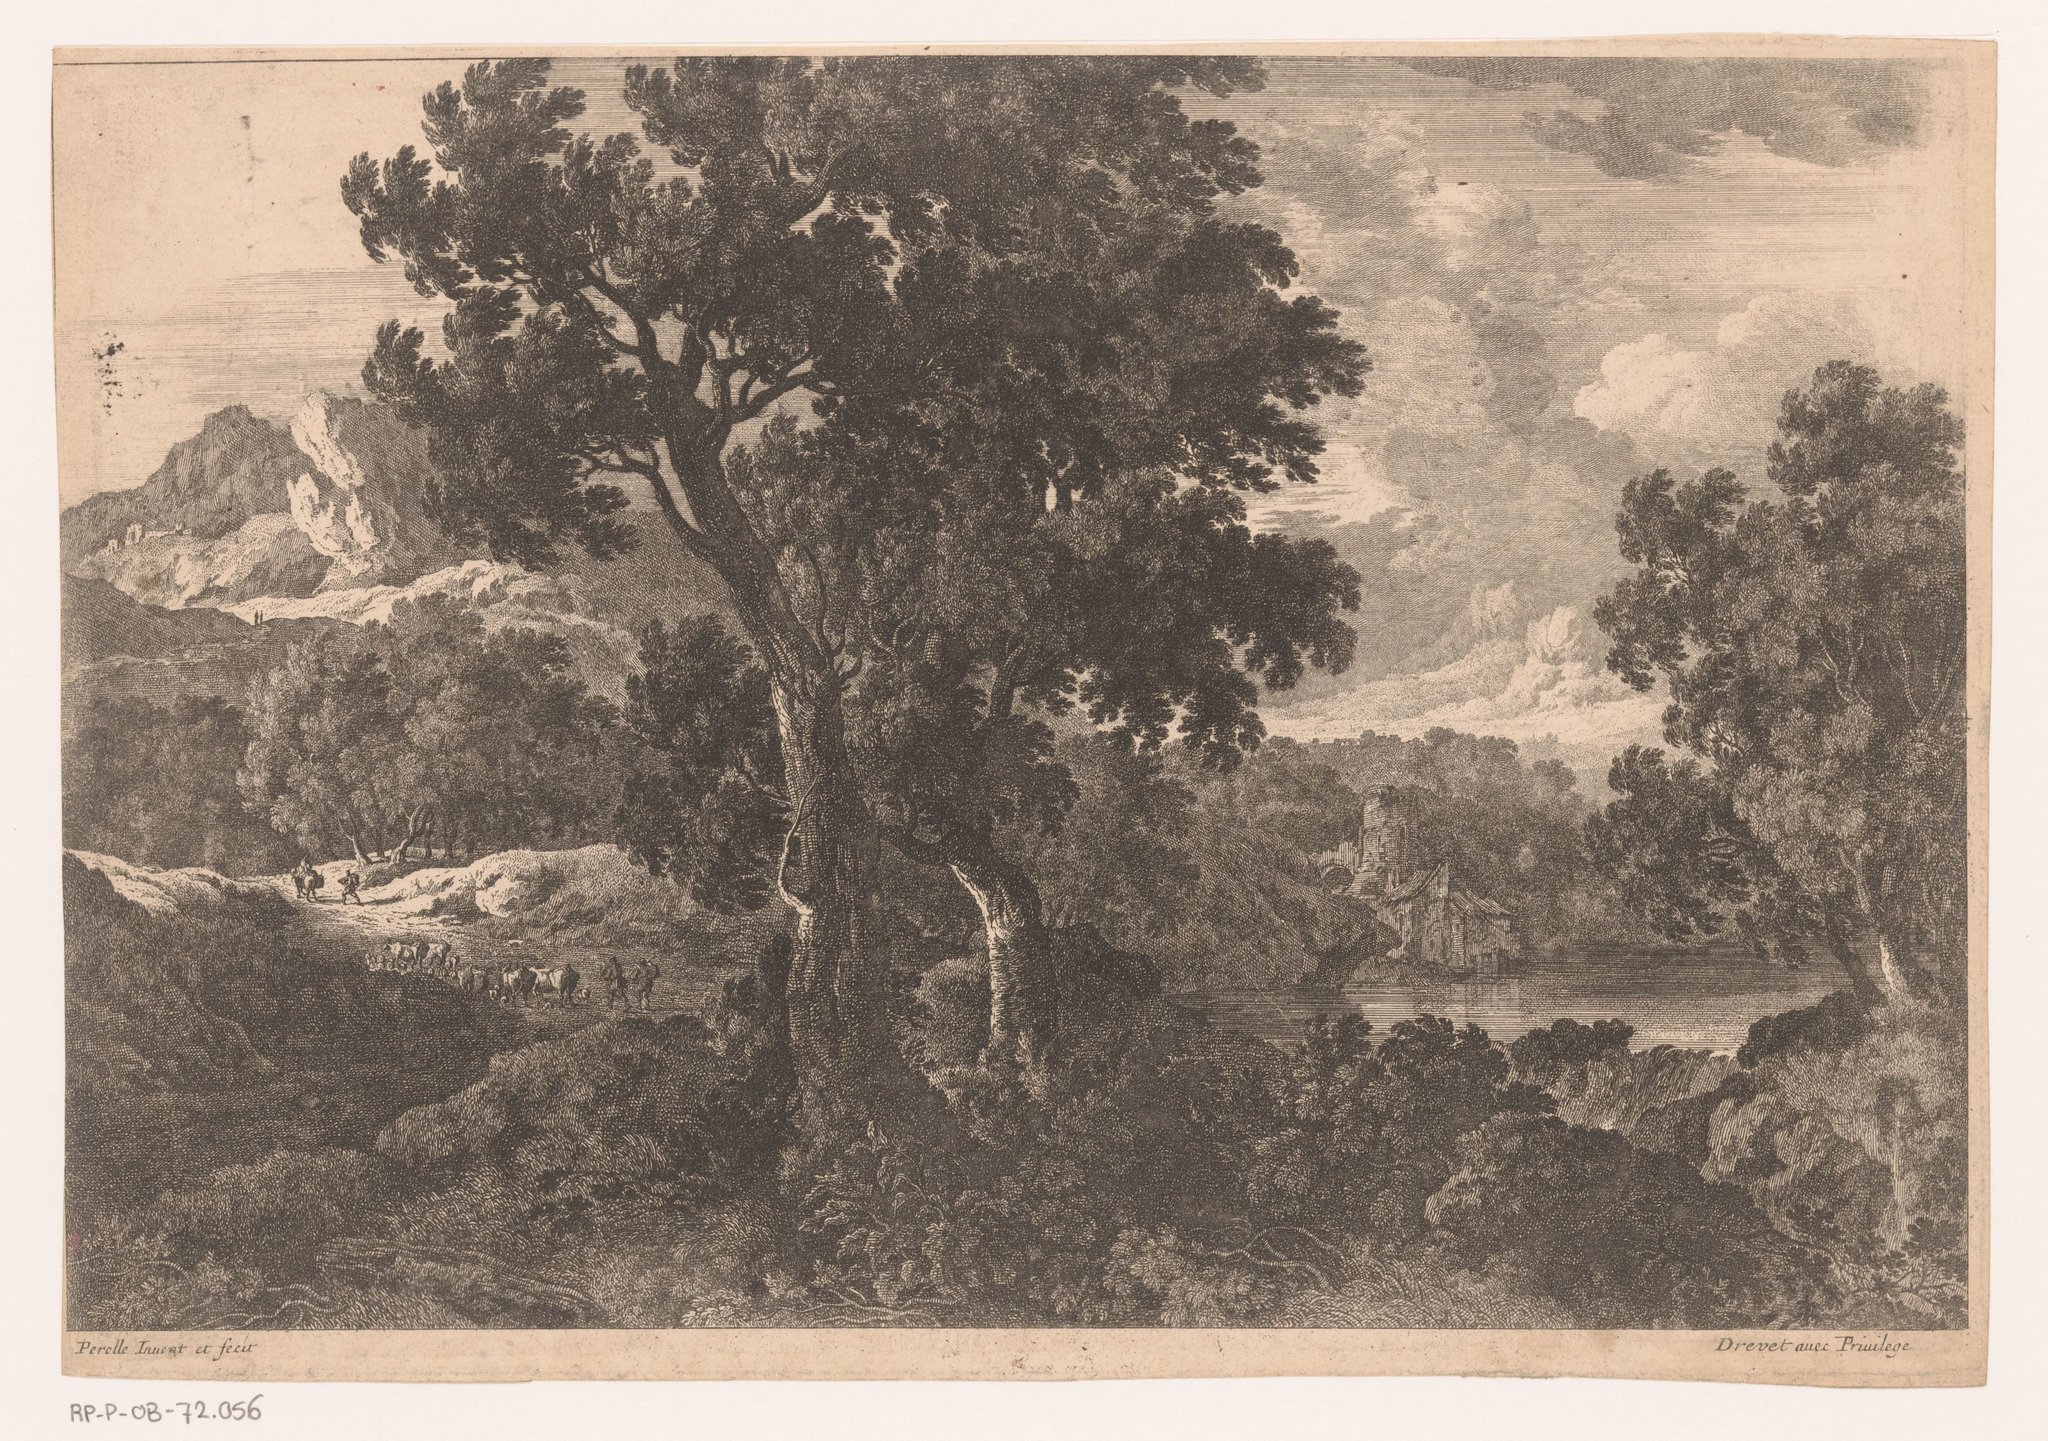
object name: print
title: Berglandschap met bomen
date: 1673-1695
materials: paper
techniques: etching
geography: paris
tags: mountains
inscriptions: collector's mark: Lugt 2228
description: Prenten met het signatuur 'Perelle' kunnen zowel door vader Gabriel als door zonen Nicolas en Adam gemaakt zijn.